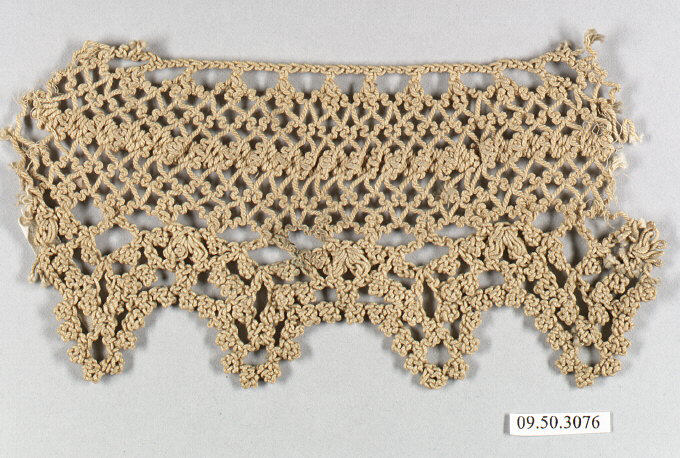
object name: sample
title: Crochet Work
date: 1801-1900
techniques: crochet